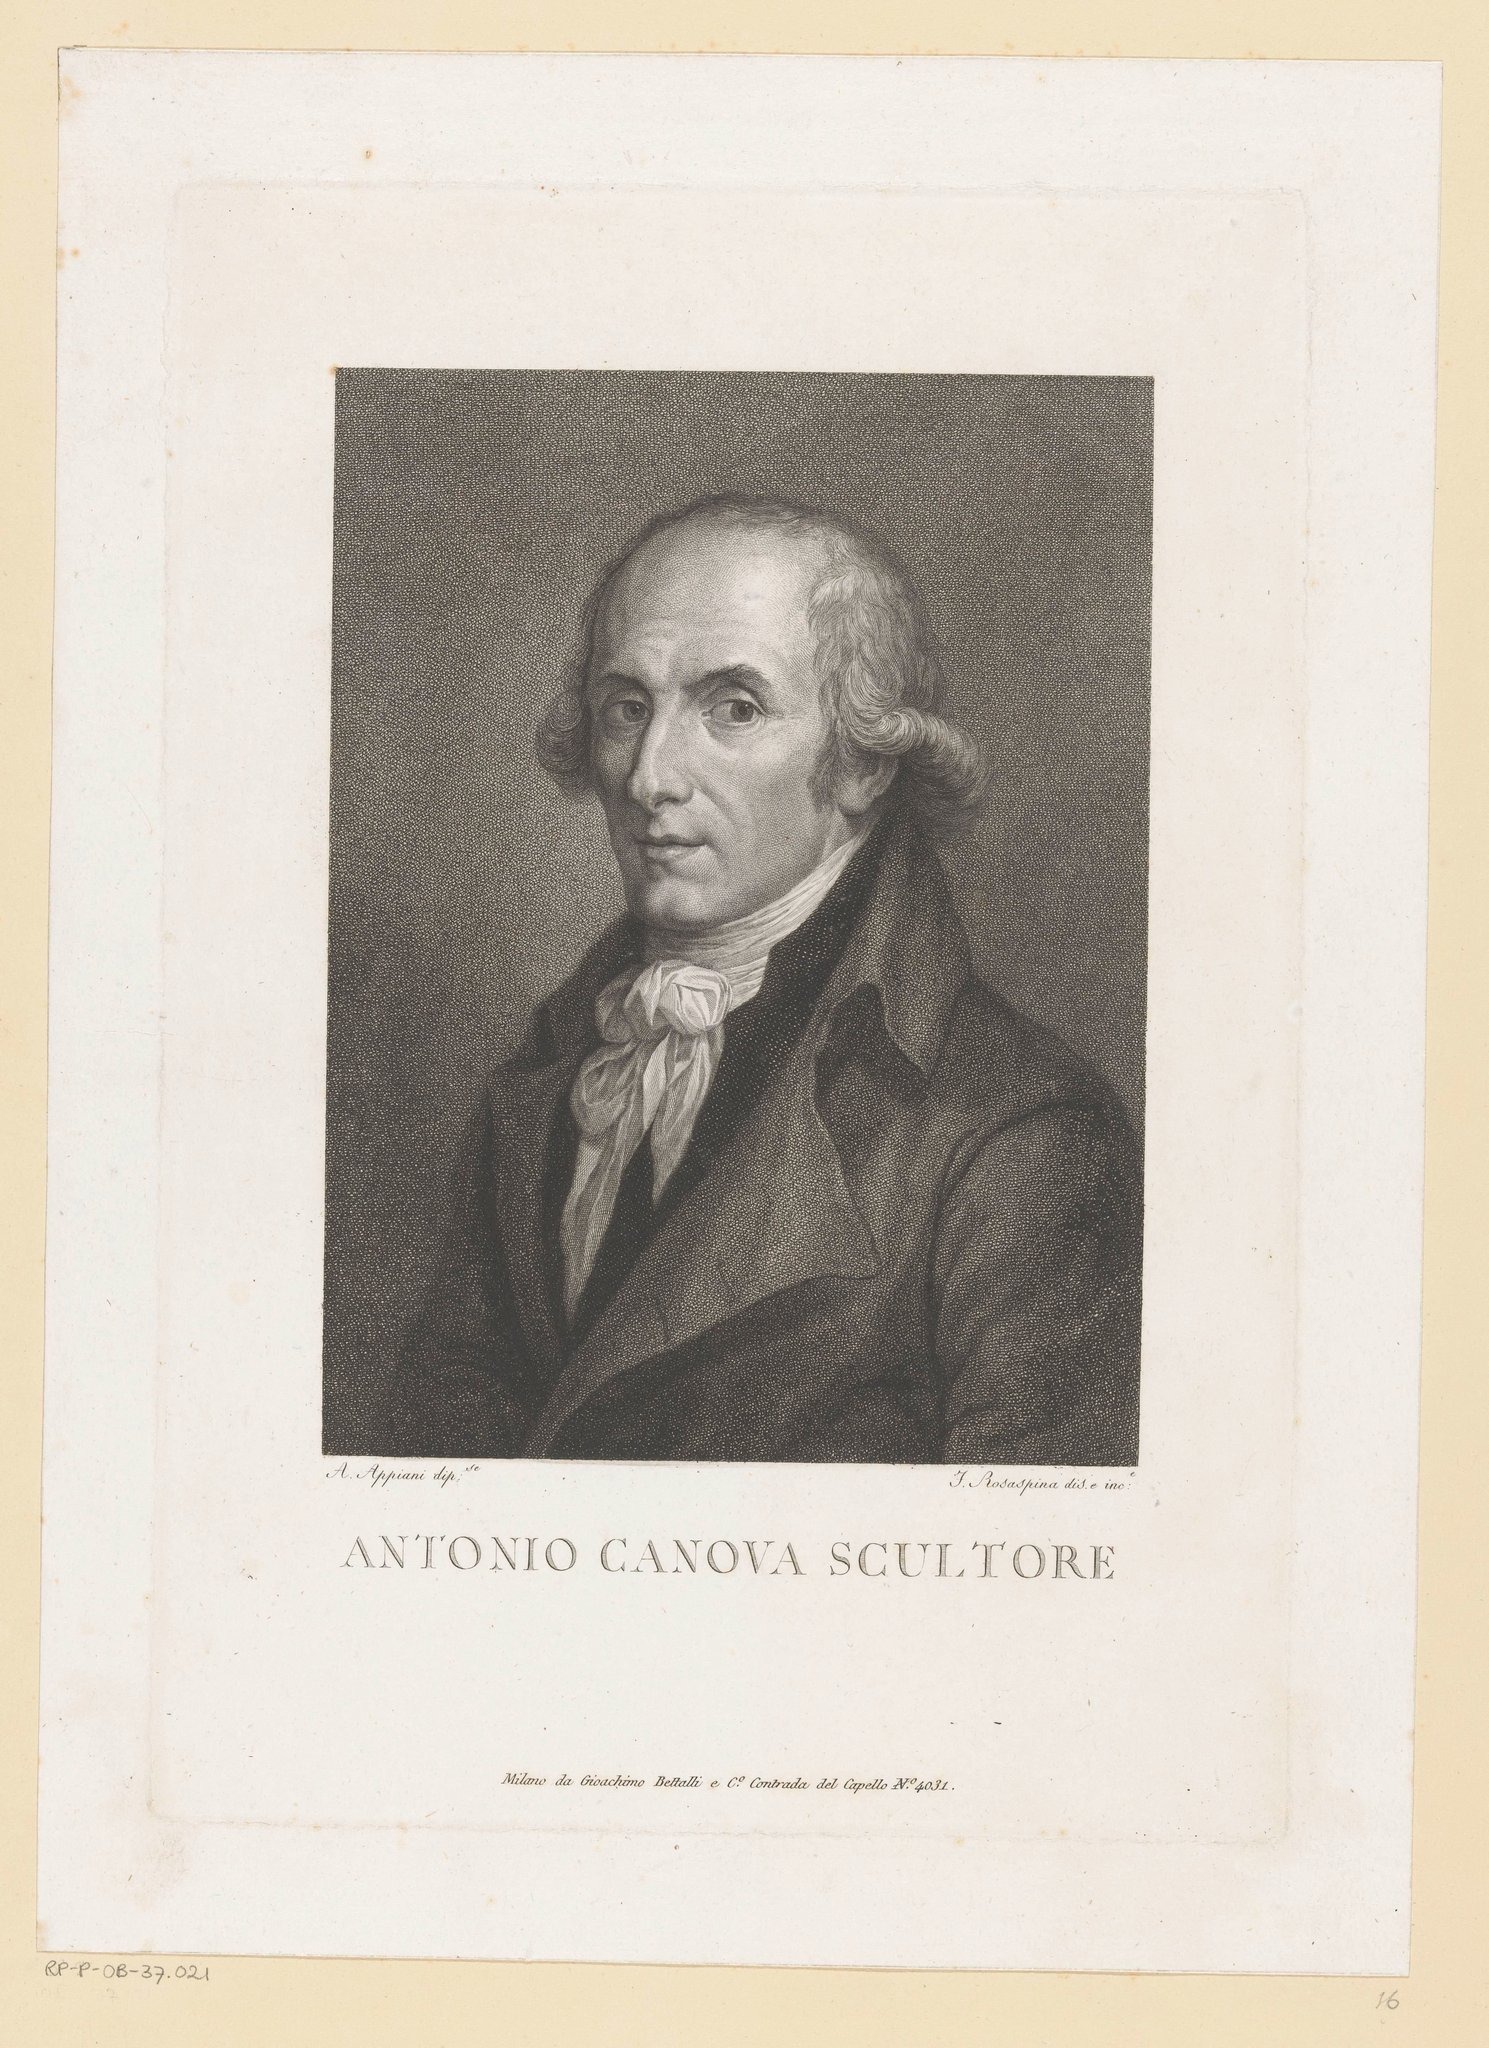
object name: print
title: Portret van beeldhouwer Antonio Canova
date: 1772-1841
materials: paper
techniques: engraving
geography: italy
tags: venice, painter, draughtsman, sculptor, antonio canova, historical persons, portrait, self-portrait of artist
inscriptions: collector's mark: Lugt 12